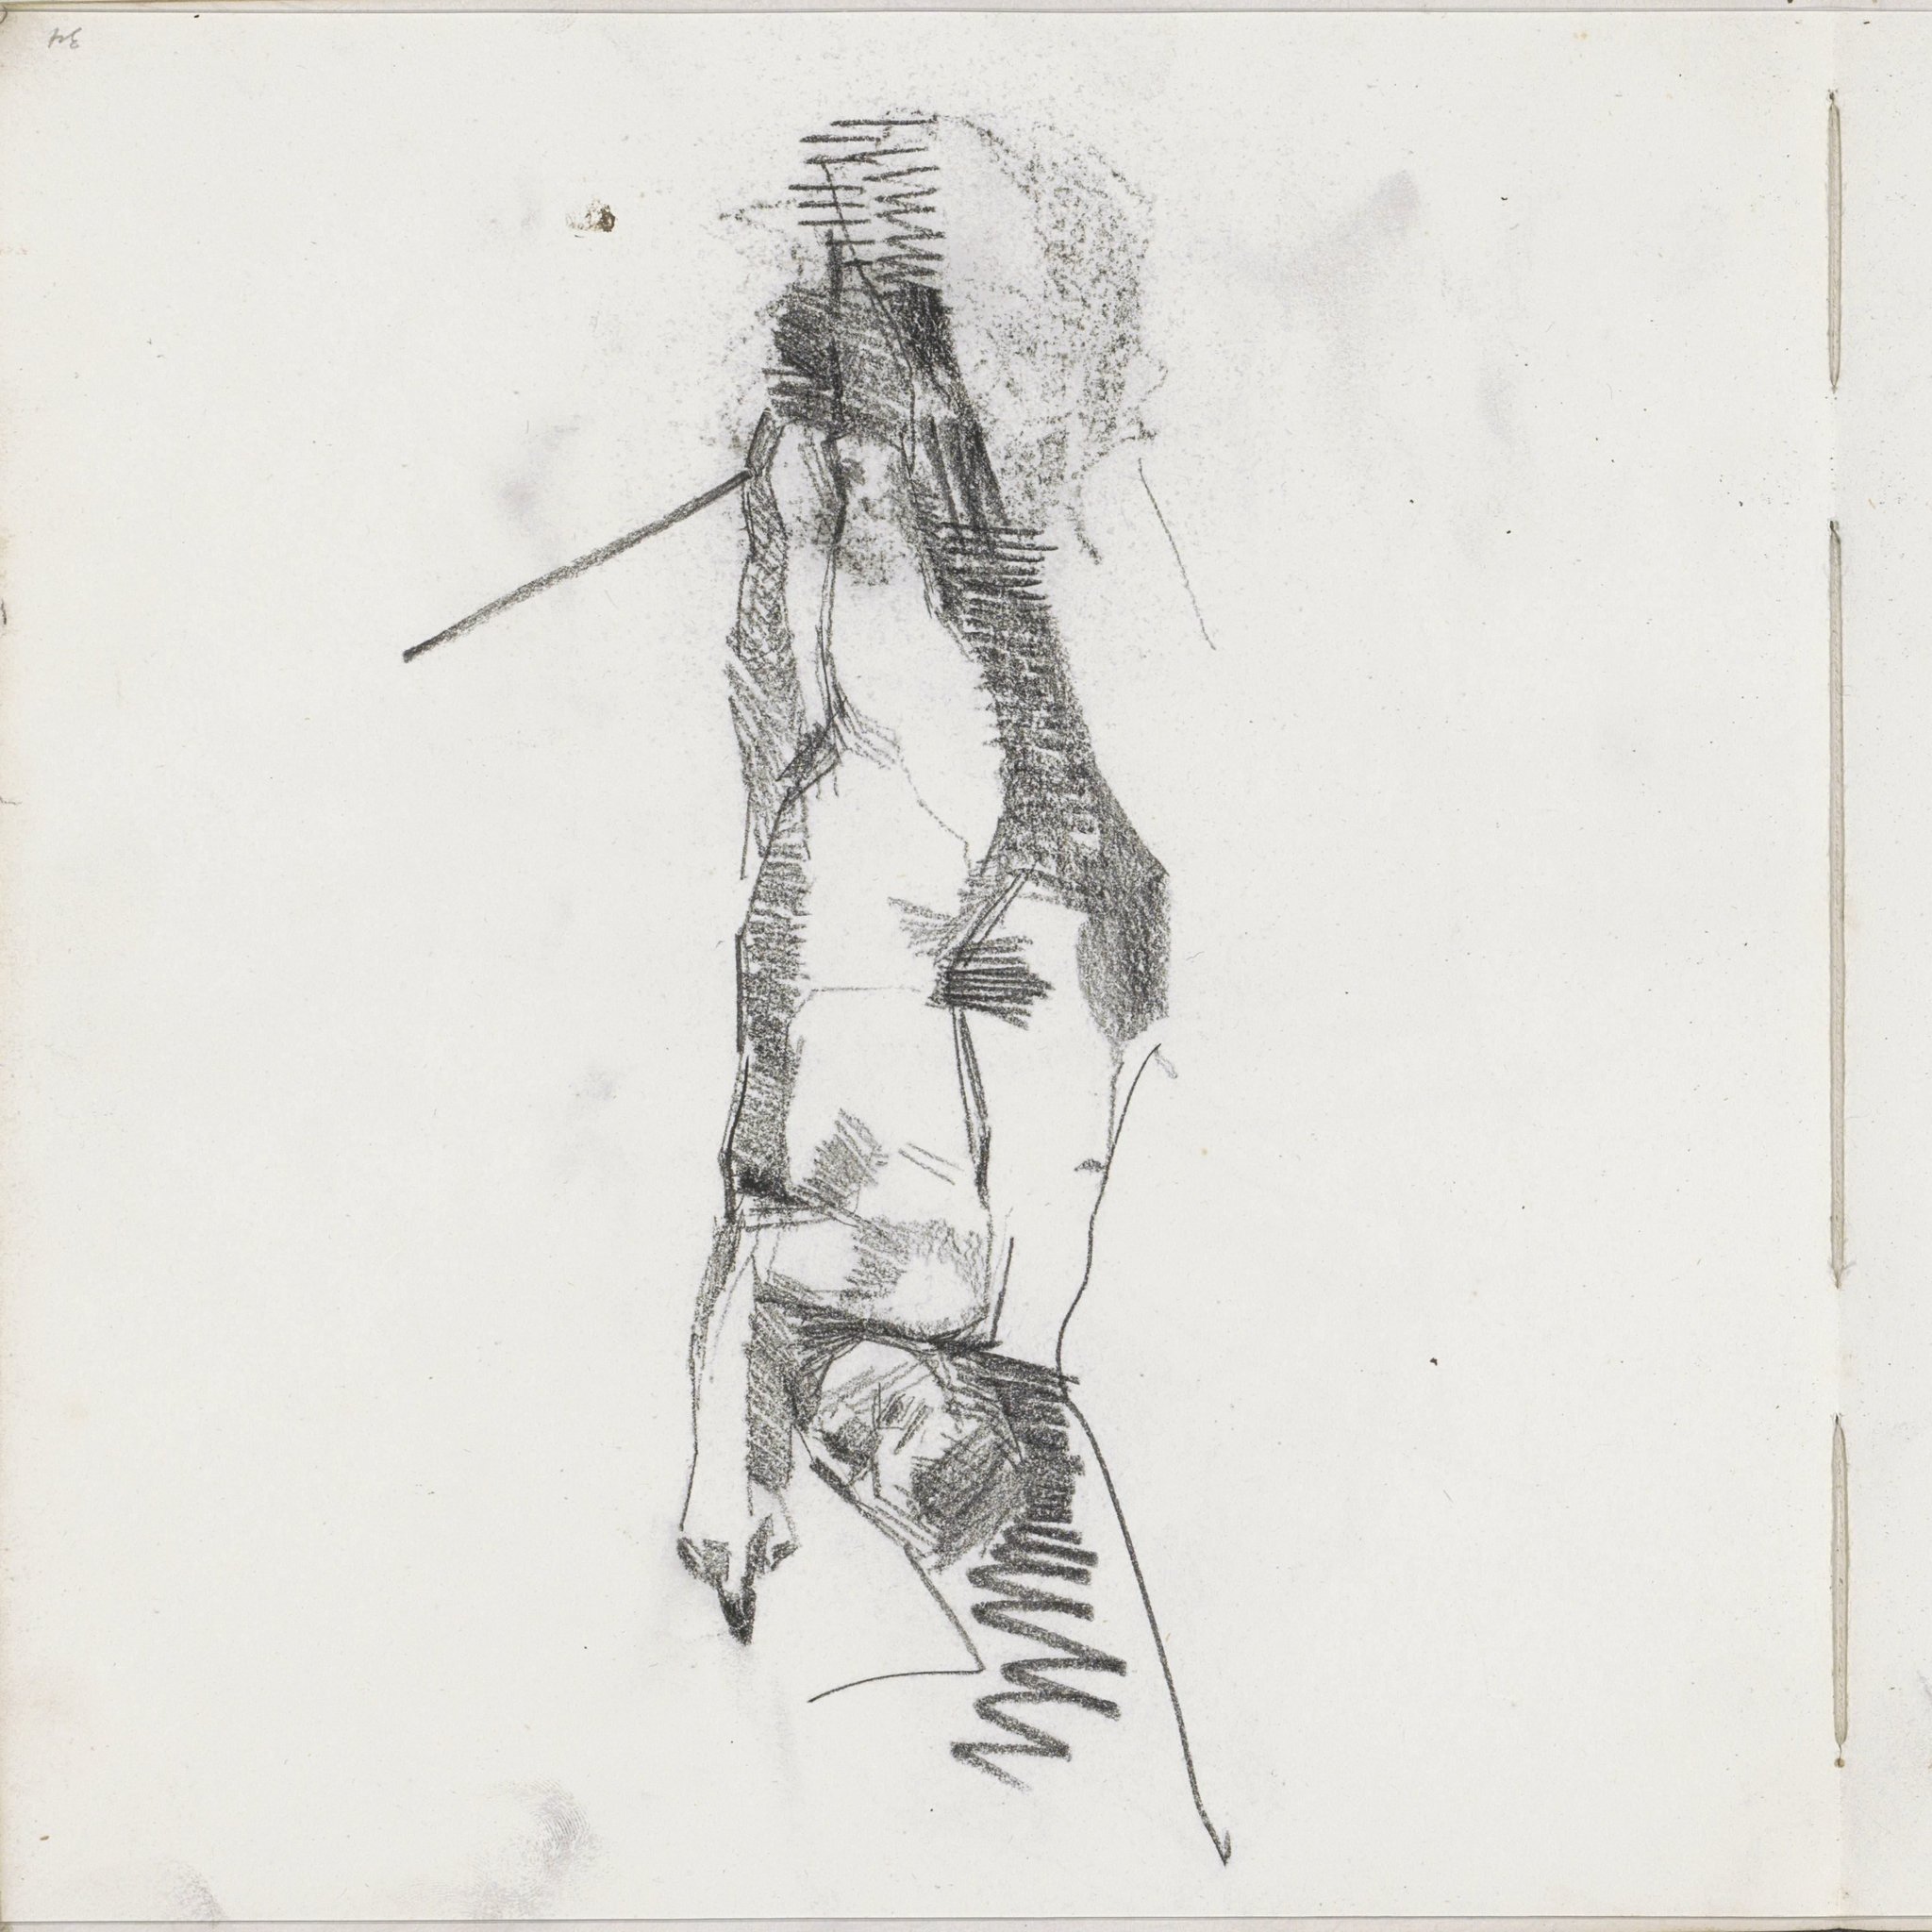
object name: sketchbook leaf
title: Reclining Female Nude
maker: isaac israels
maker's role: draughtsman, painter, print maker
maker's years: 1865-1934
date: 1875-1934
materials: chalk, paper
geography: the hague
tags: the (nude) human figure; 'corpo humano' (ripa) - aa - female human figure (+ lying)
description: Blad 23 verso uit schetsboek IX met 28 bladen.